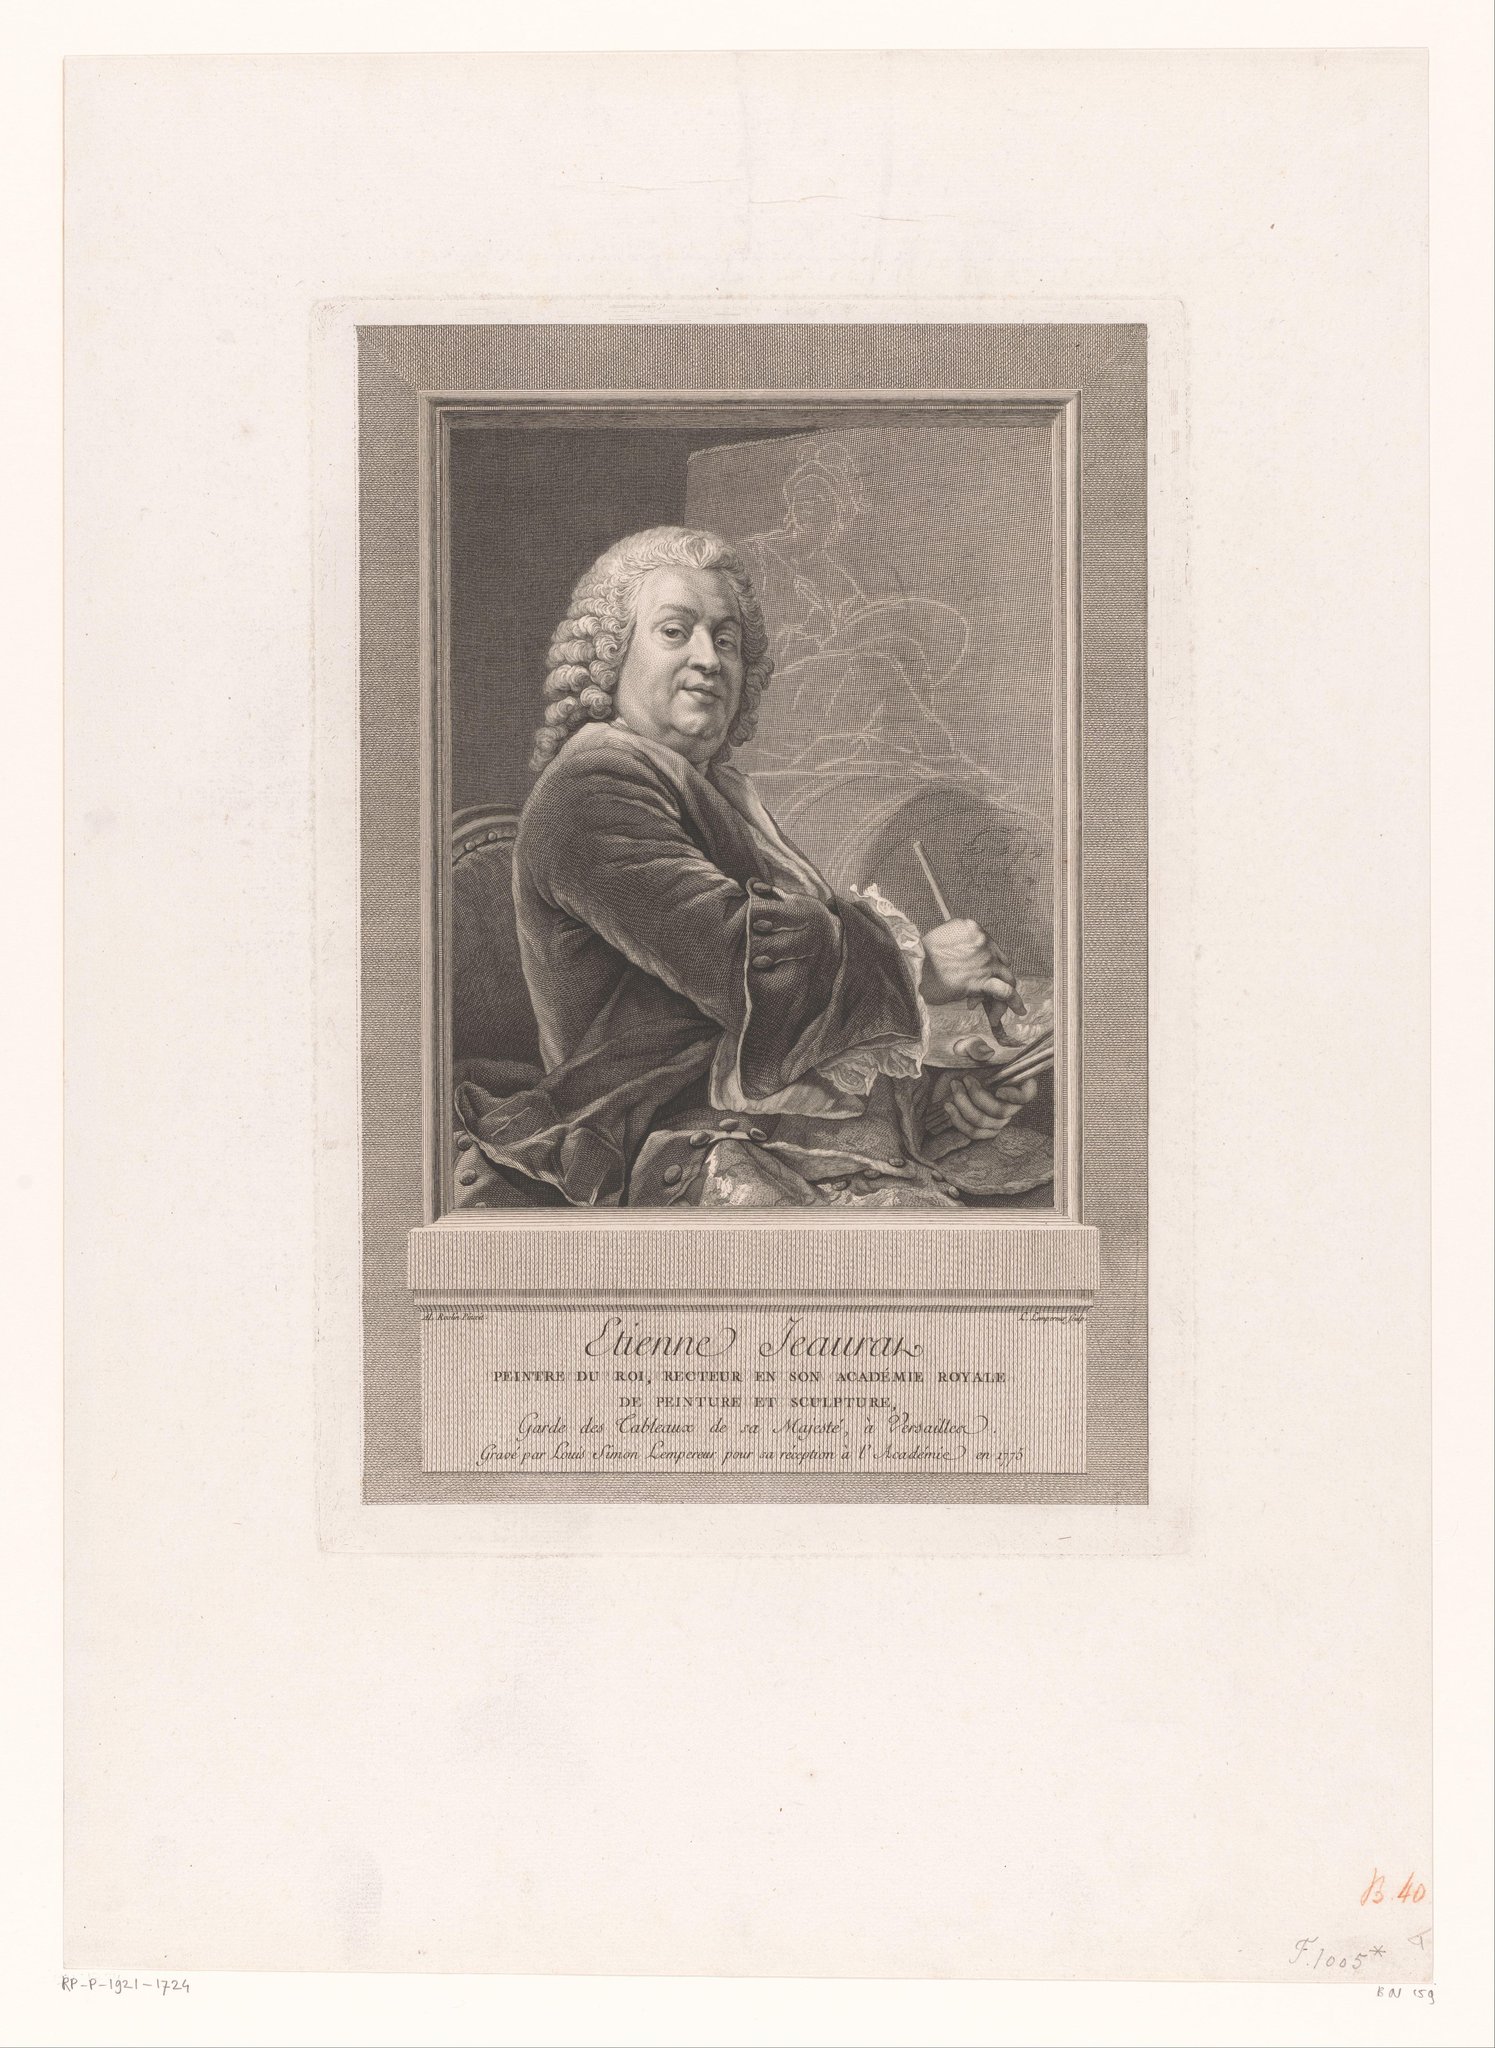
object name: print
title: Etienne Jeuarat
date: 1775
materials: paper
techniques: engraving, etching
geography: france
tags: paris, draughtsman, etienne jeaurat, historical persons, portrait, self-portrait of painter, painter at work, in his studio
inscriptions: collector's mark: Lugt 2233